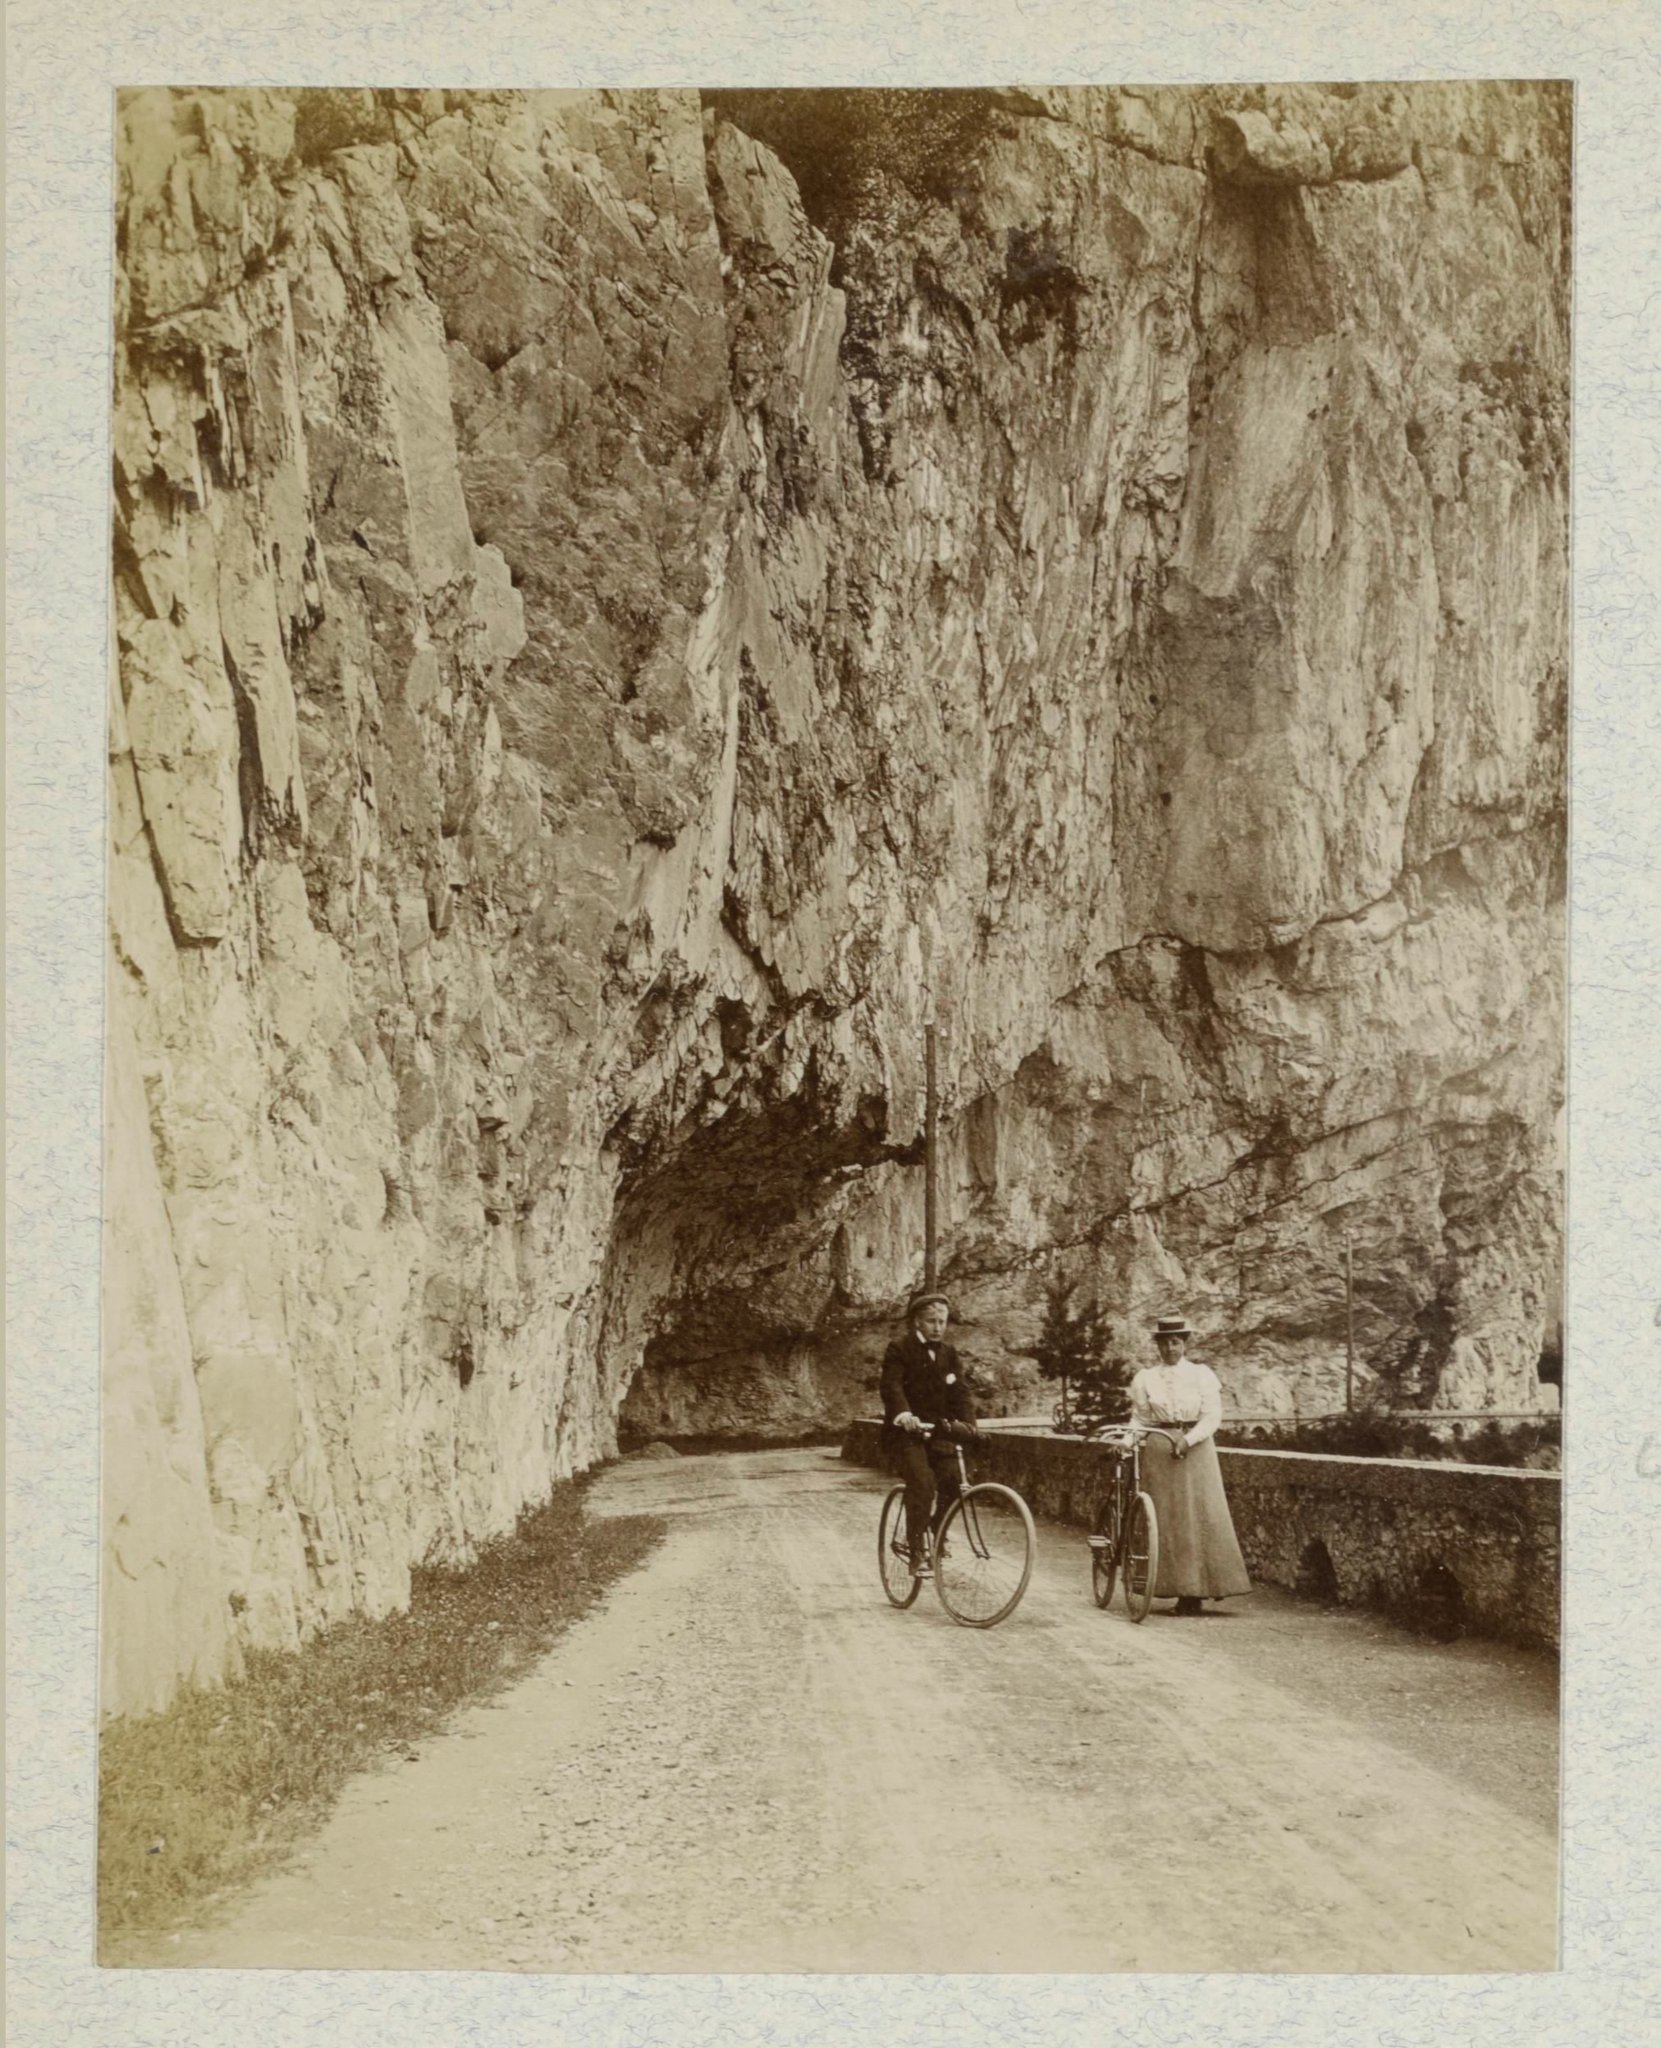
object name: photograph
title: Vakantie in Zwitserland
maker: andries augustus boom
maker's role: amateurfotograaf, handelaar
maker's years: 1878-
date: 1805-1899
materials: photographic support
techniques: photography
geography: switzerland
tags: amsterdam, andries augustus boom, switzerland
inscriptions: date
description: Vakantie in Zwitserland, de Axenstrasse. Onderdeel van het fotoalbum van de familie Boom-Gonggrijp in Suriname en Curaçao.